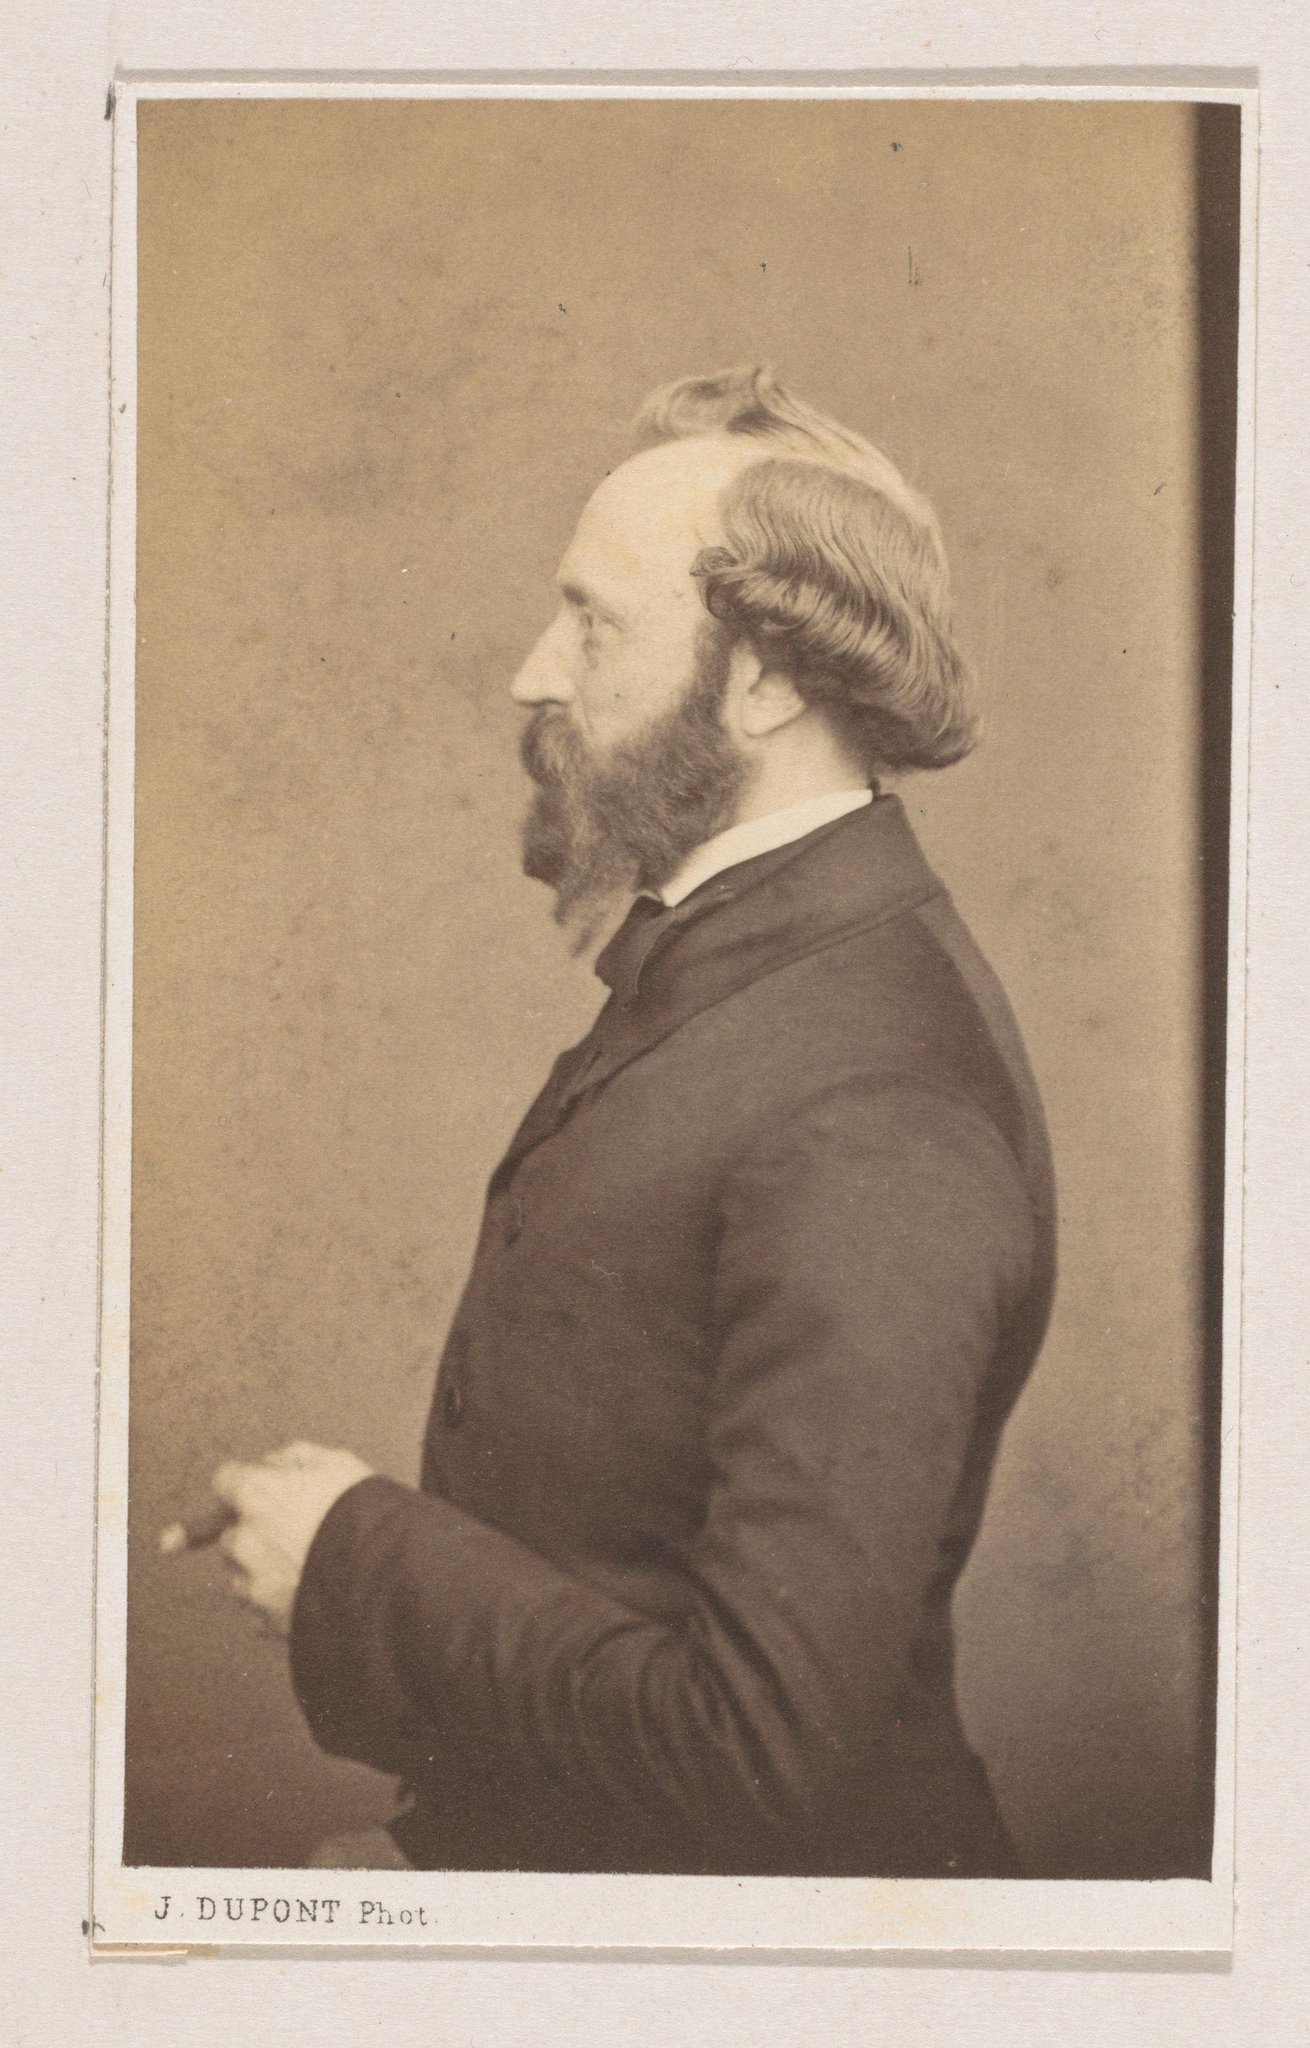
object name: photograph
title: L'École d'Anvers. Portraits biographies cartes de visite. Collection Dupont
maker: joseph dupont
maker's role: fotograaf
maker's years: 1818-1901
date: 1861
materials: cardboard, paper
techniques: albumen print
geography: antwerp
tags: painter, historical persons, portrait, self-portrait of painter, portrait, self-portrait of artist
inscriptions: inscription: ‘ETABLISSEMENT PHOTOGRAPHIQUE/ de/ J. DUPONT/ Place de Meir 32/ ANVERS/ Maison fondée en 1853’, inscription: ‘de Wilde’